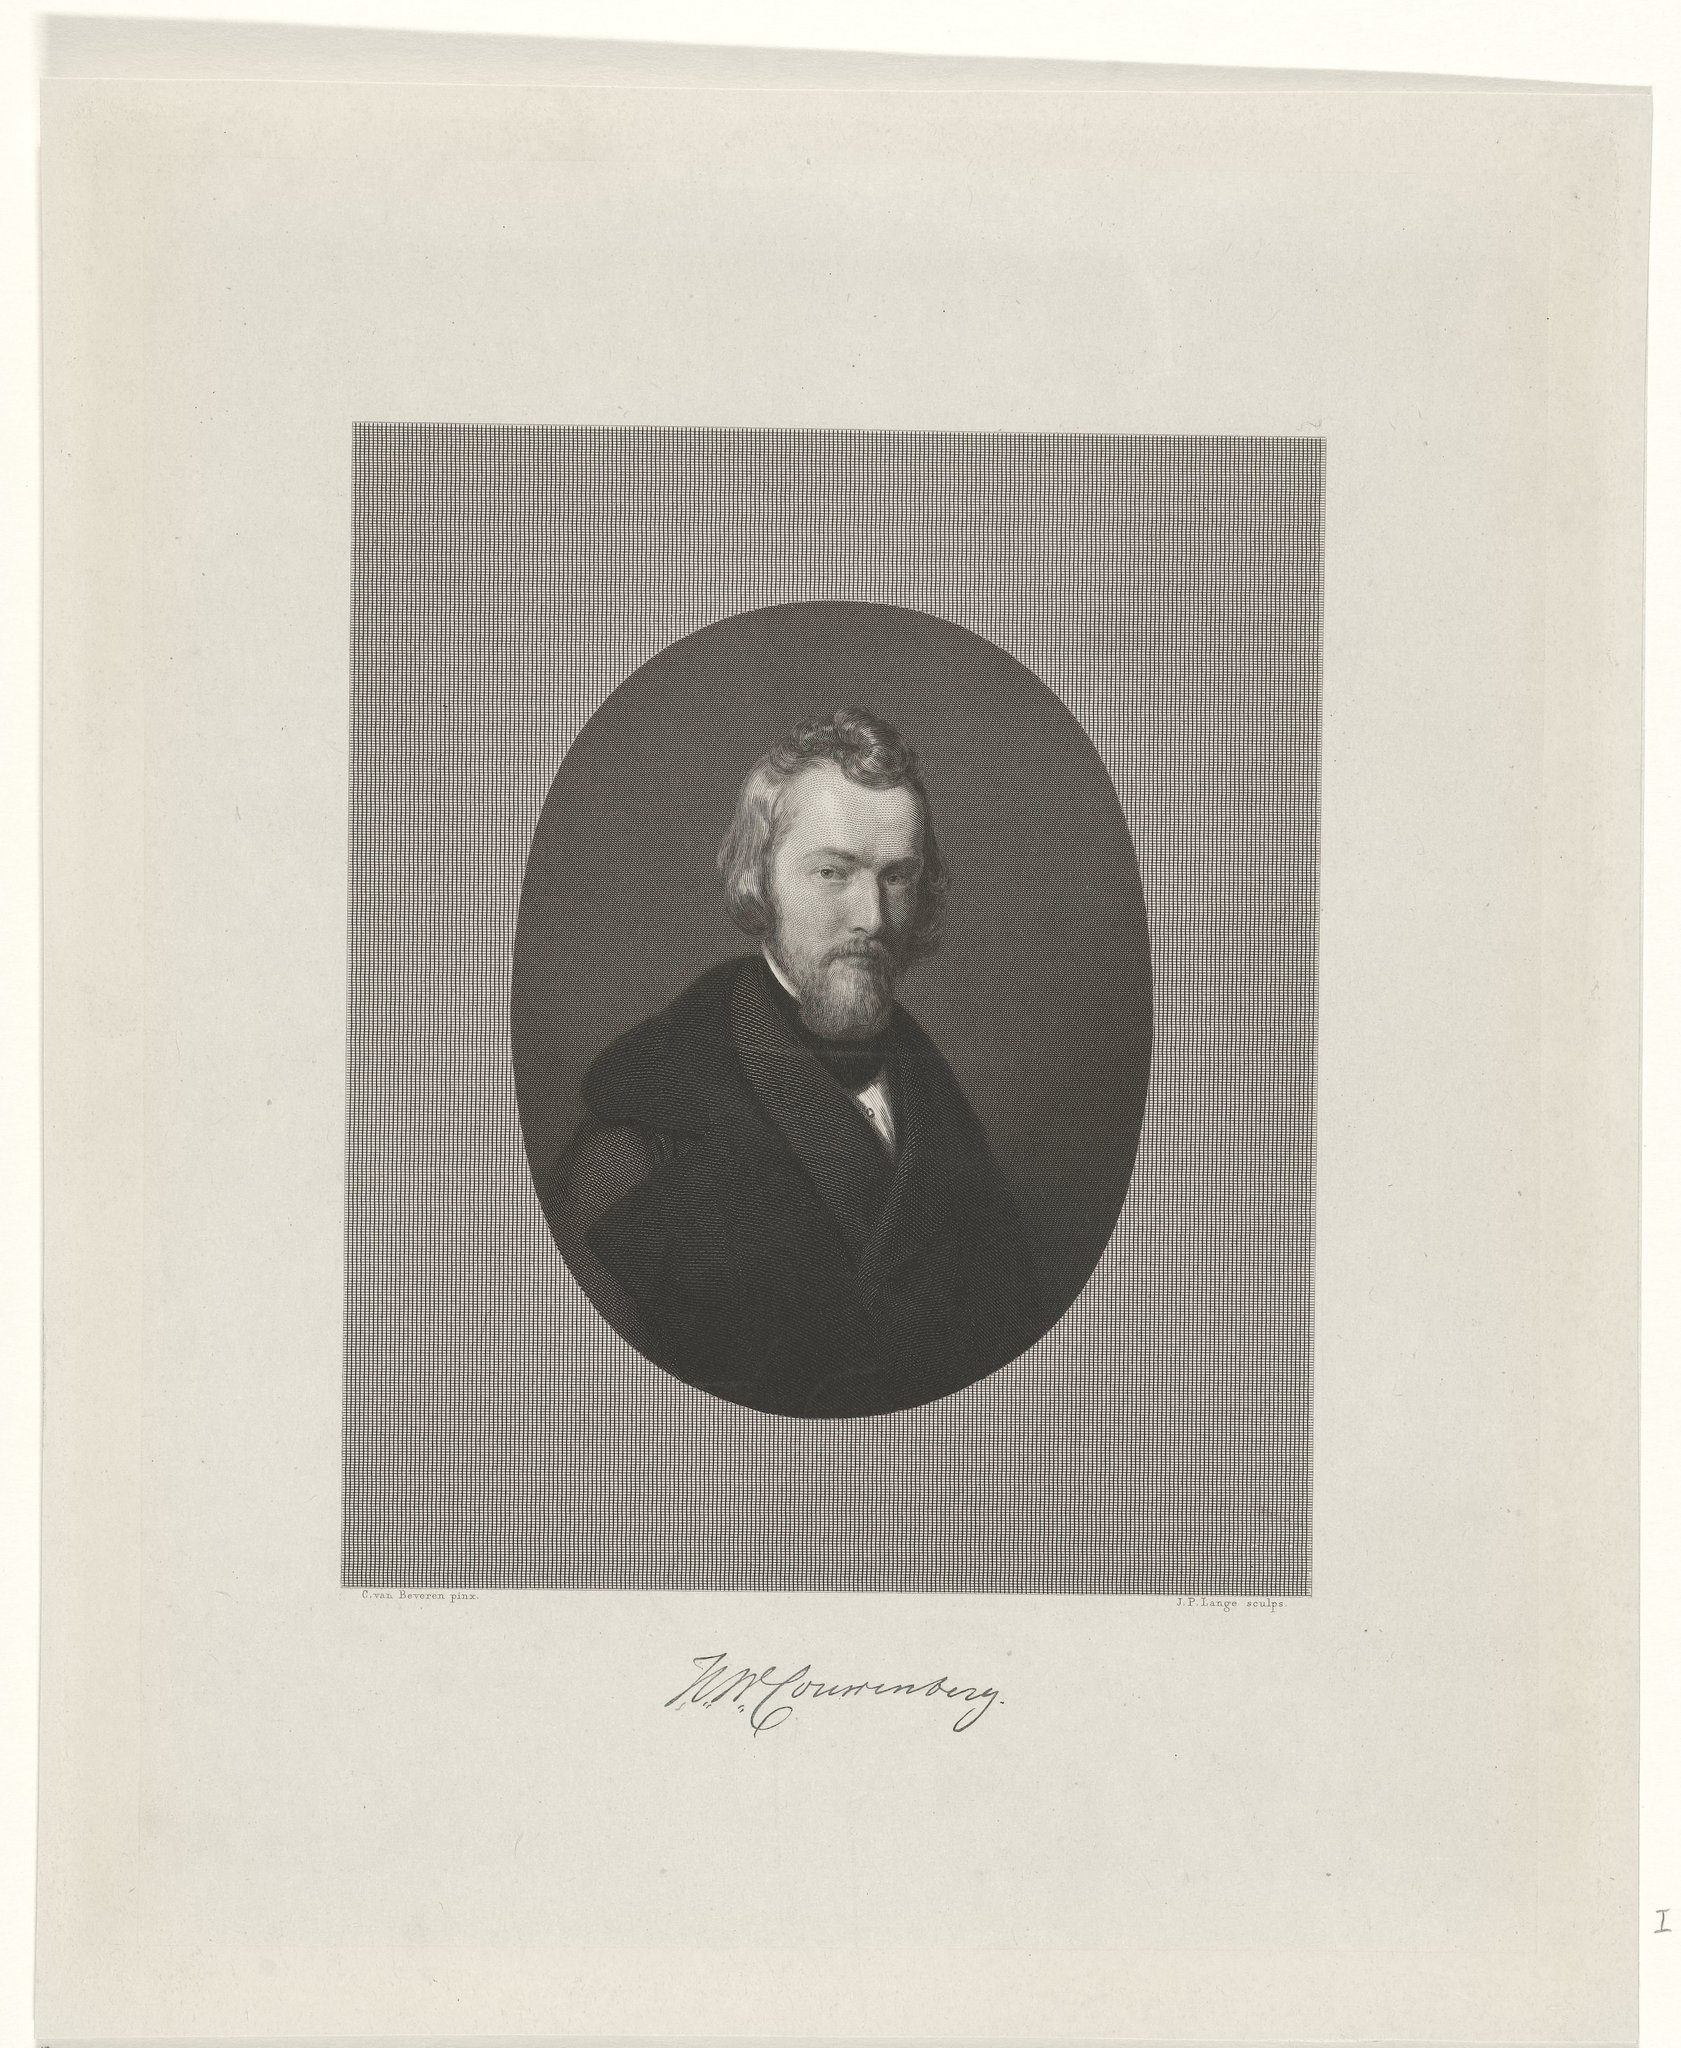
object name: print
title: Portret van Henricus Wilhelmus Couwenberg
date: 1845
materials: paper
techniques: engraving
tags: the hague, amsterdam, print maker, draughtsman, henricus wilhelmus couwenberg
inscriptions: collector's mark: Lugt 2228, inscription: ‘H.W. Couwenberg’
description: Portretbuste in ovaal naar rechts van Henricus Wilhelmus Couwenberg, graveur, tekenaar en schilder.